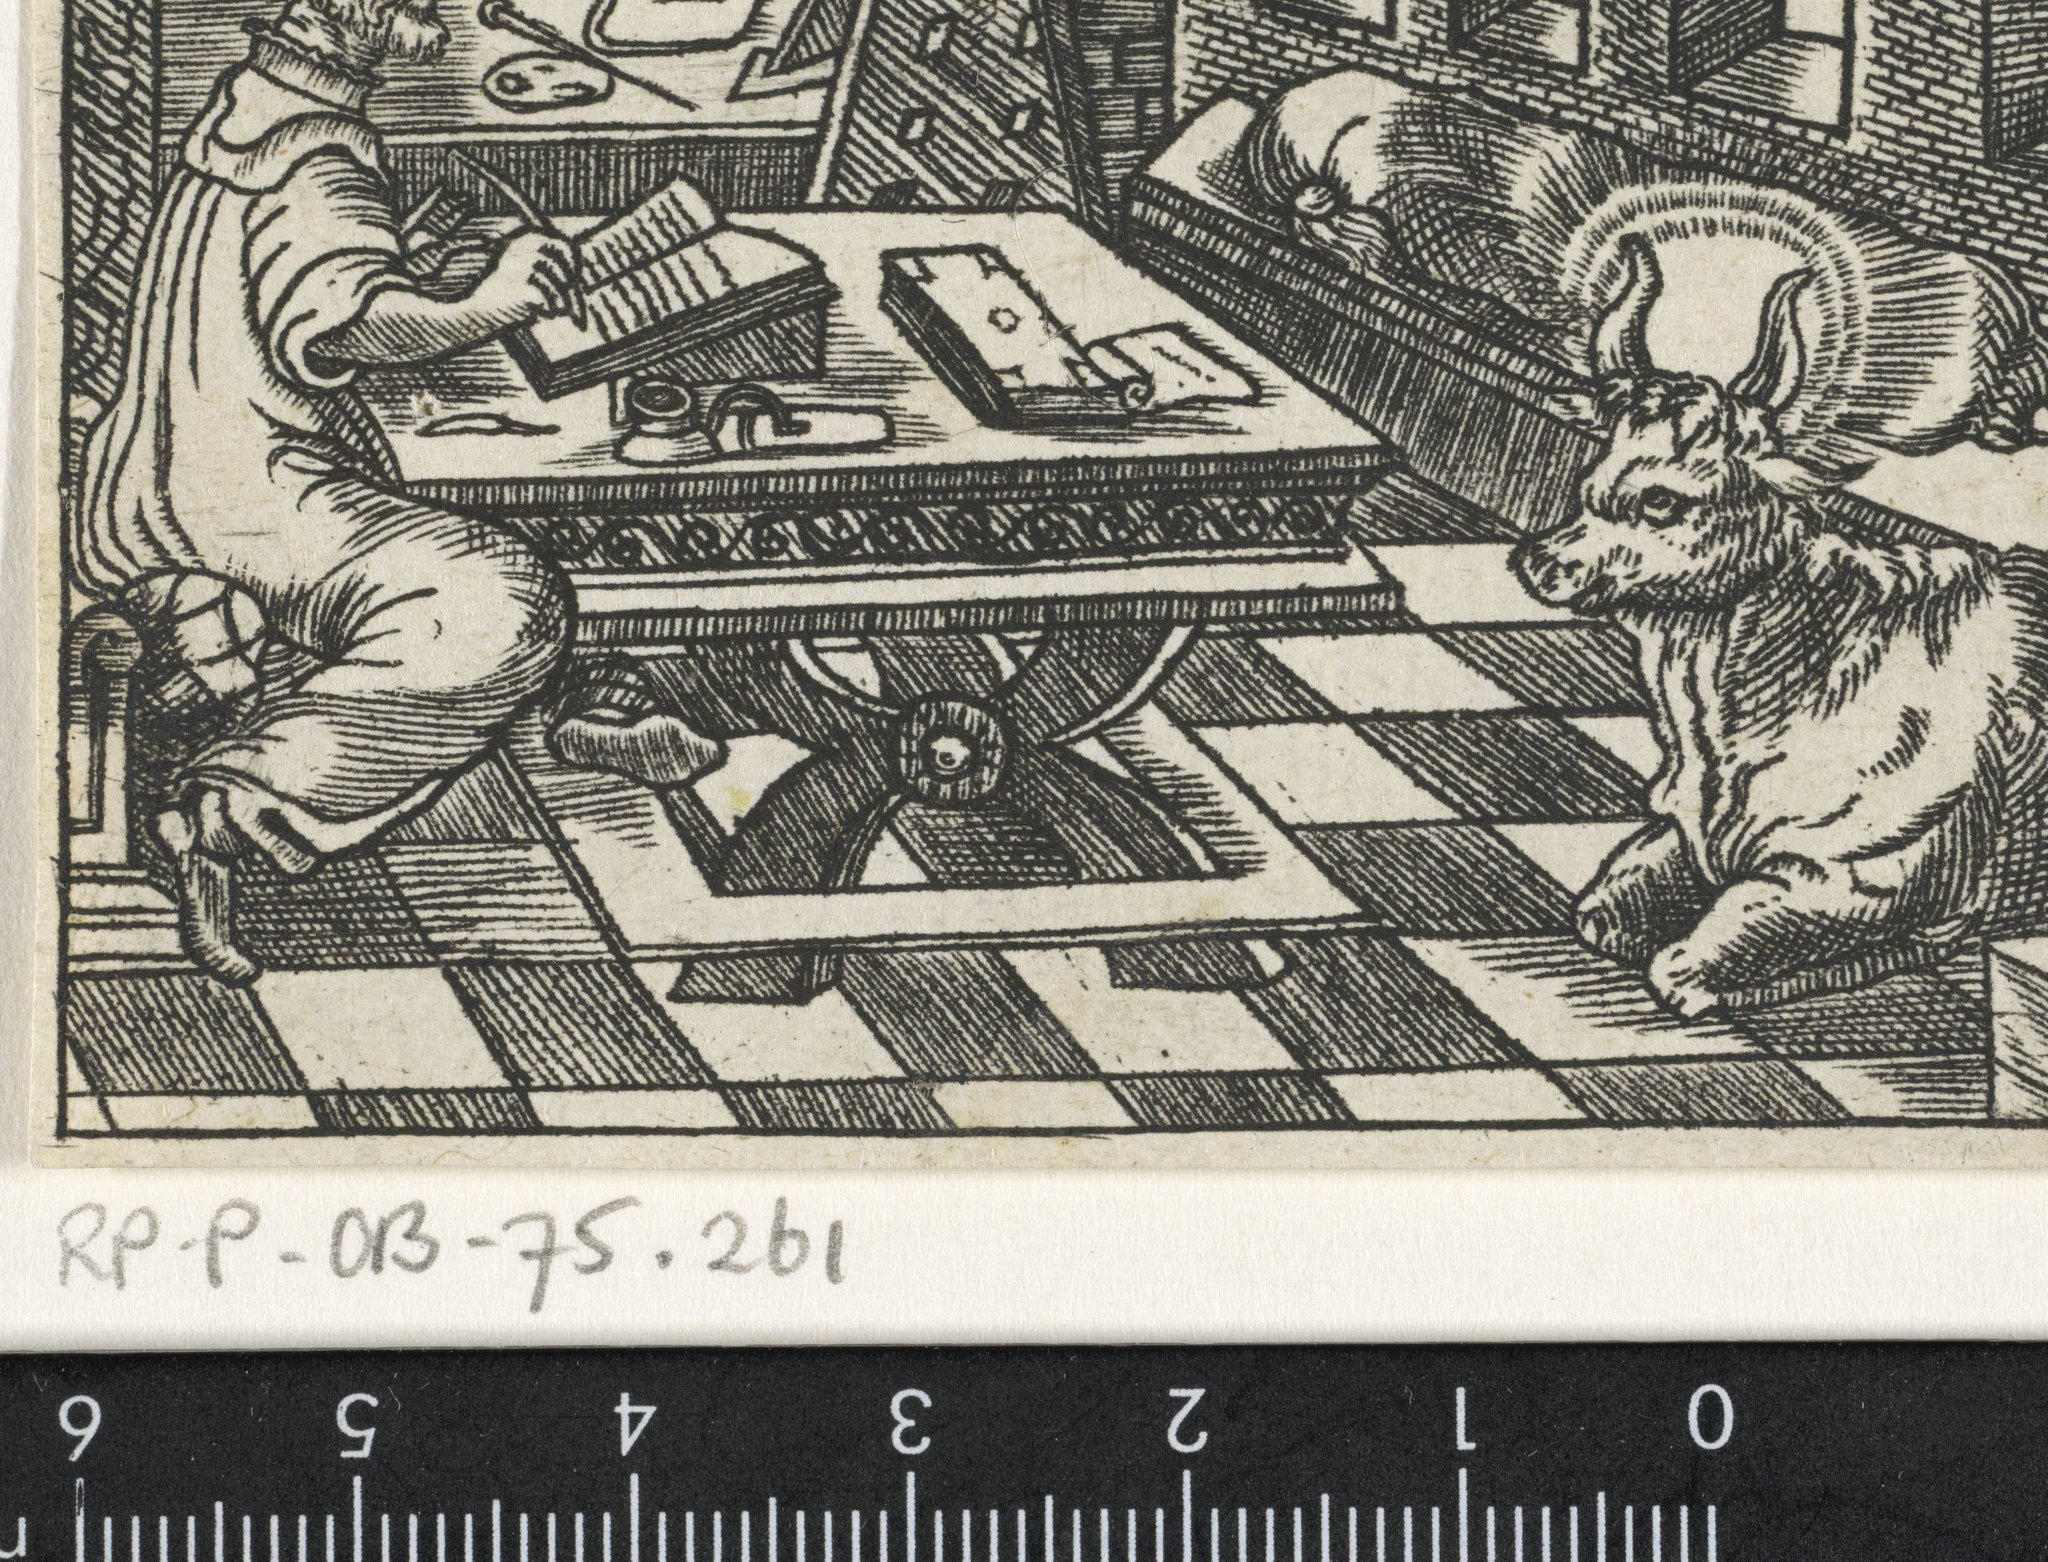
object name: print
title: Lucas de evangelist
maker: Anonymous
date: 1500-1700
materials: paper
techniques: engraving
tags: st. luke writing his gospel, inspiratory figure present, e.g.: angel(s), dove, hand of god, mary, st. luke writing his gospel, usually a (winged) ox present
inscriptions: collector's mark: Lugt 2228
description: De evangelist Lucas schrijft zijn evangelie aan een tafel. Hij ontvangt inspiratie van de Heilige Geest, die als een duif door het raam komt binnenvliegen. Rechts ligt de os. In het raam een visioen van Christus aan het kruis. Achter in de kamer een schildersezel, palet, schildersstok en hoed.